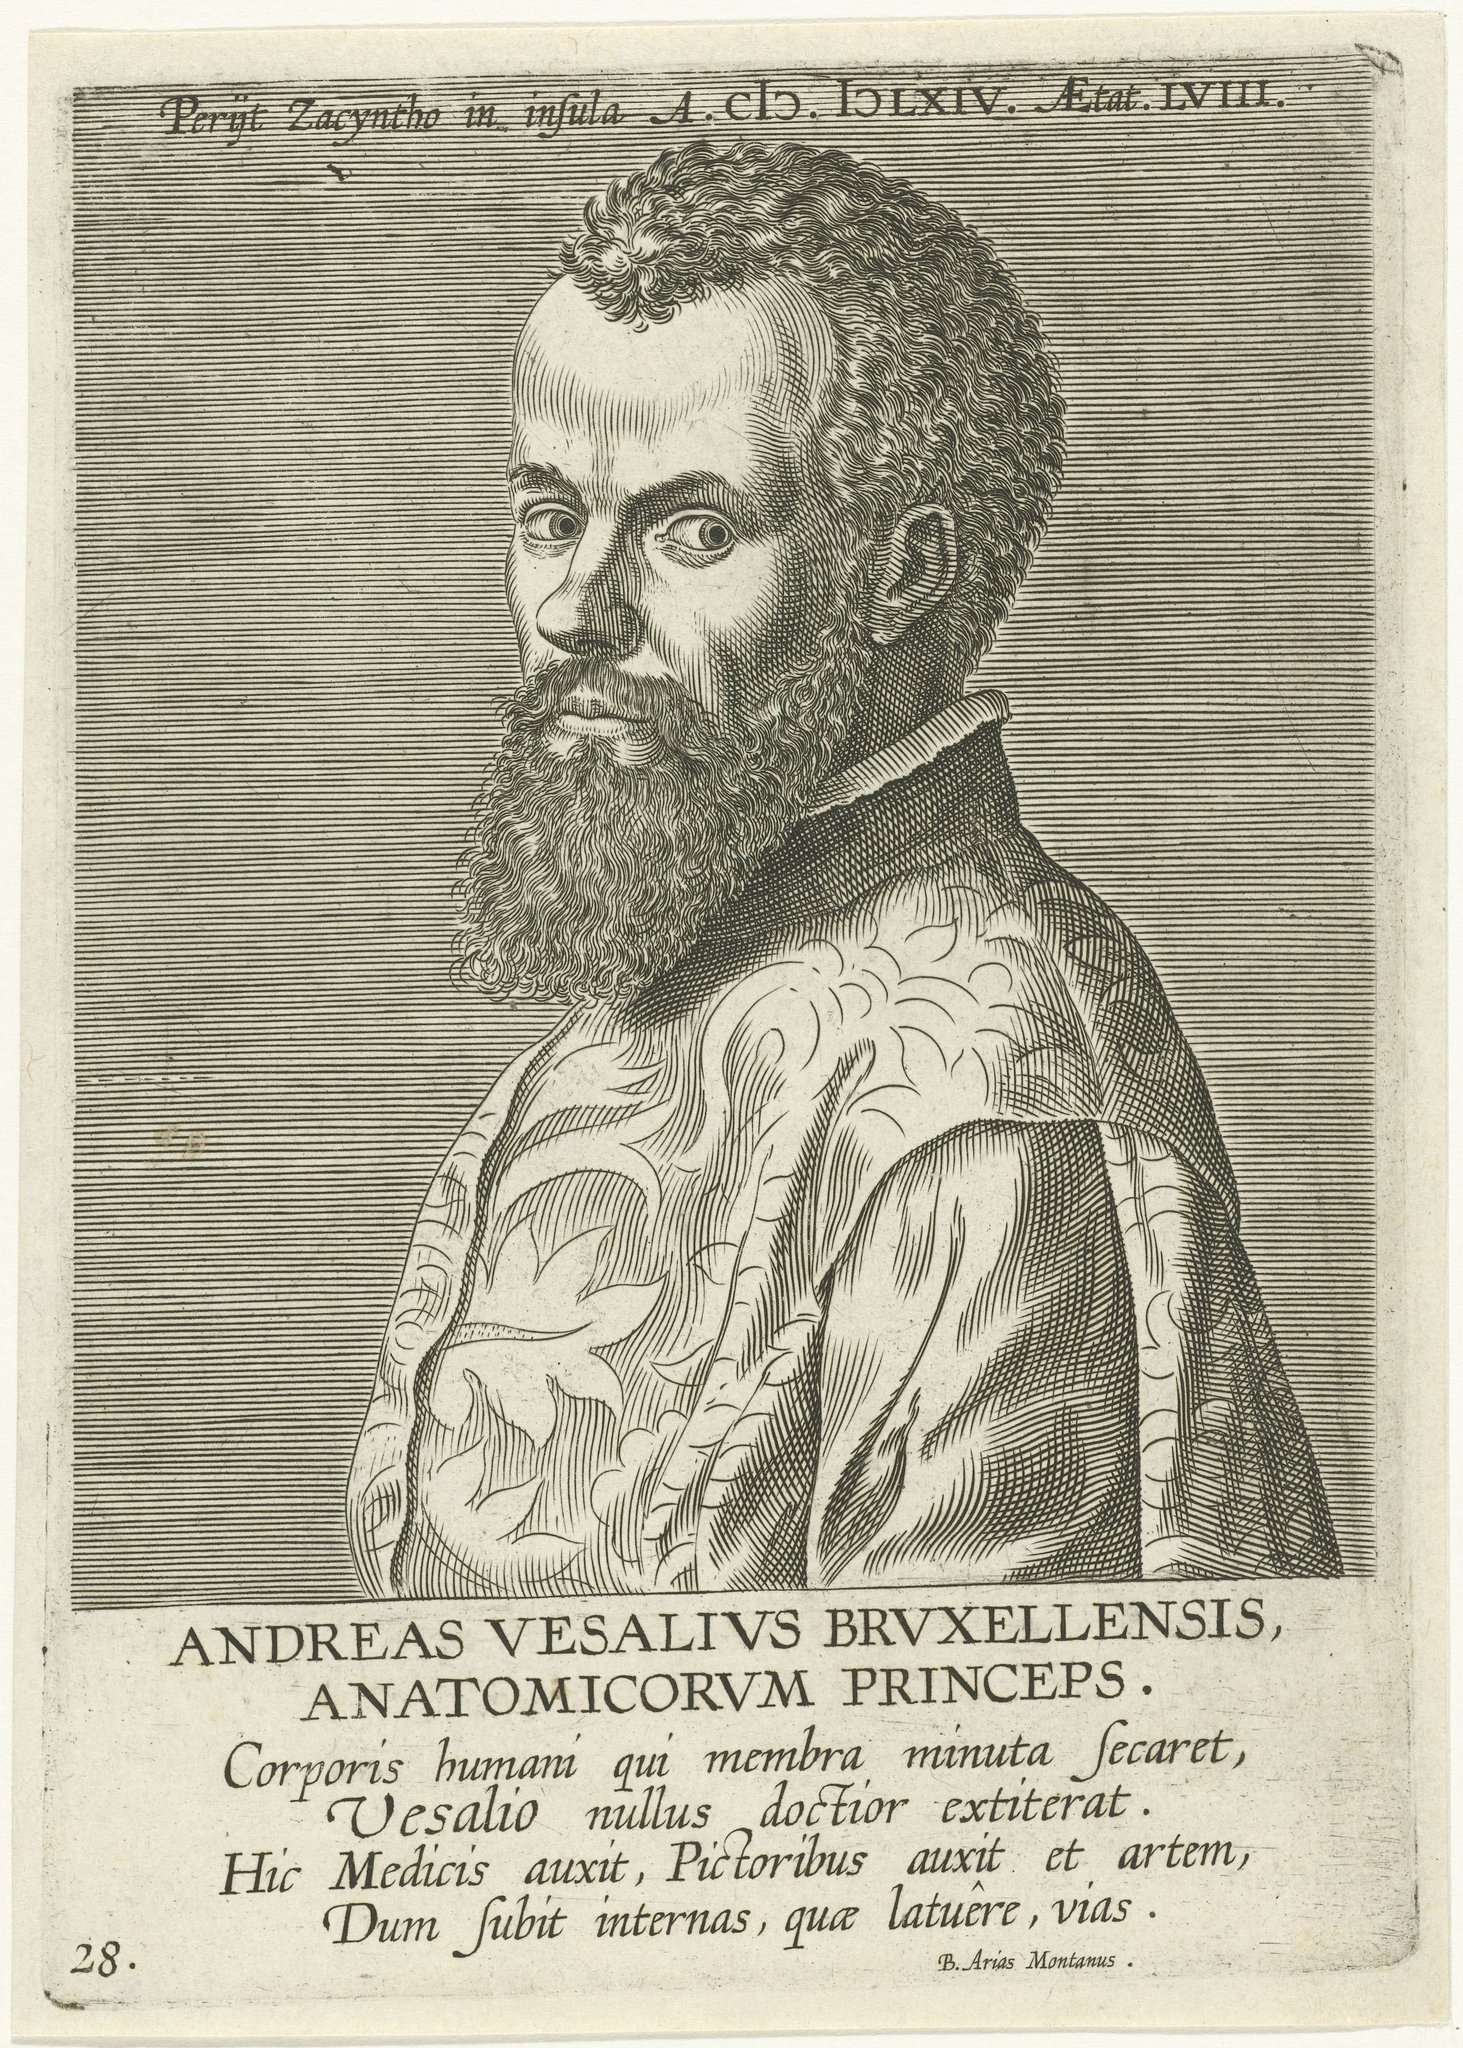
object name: print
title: Illustrium Galliae Belgicae scriptorum icones et elogi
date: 1604-1608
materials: paper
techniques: engraving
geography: antwerp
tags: brussels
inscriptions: collector's mark: Lugt 2228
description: Portret van Andreas Vesalius, Brusselse anatoom en arts. Buste naar links. De prent heeft een Latijns boven- en onderschrift en maakt deel uit van een serie van beroemde Nederlandse en Vlaamse geleerden.